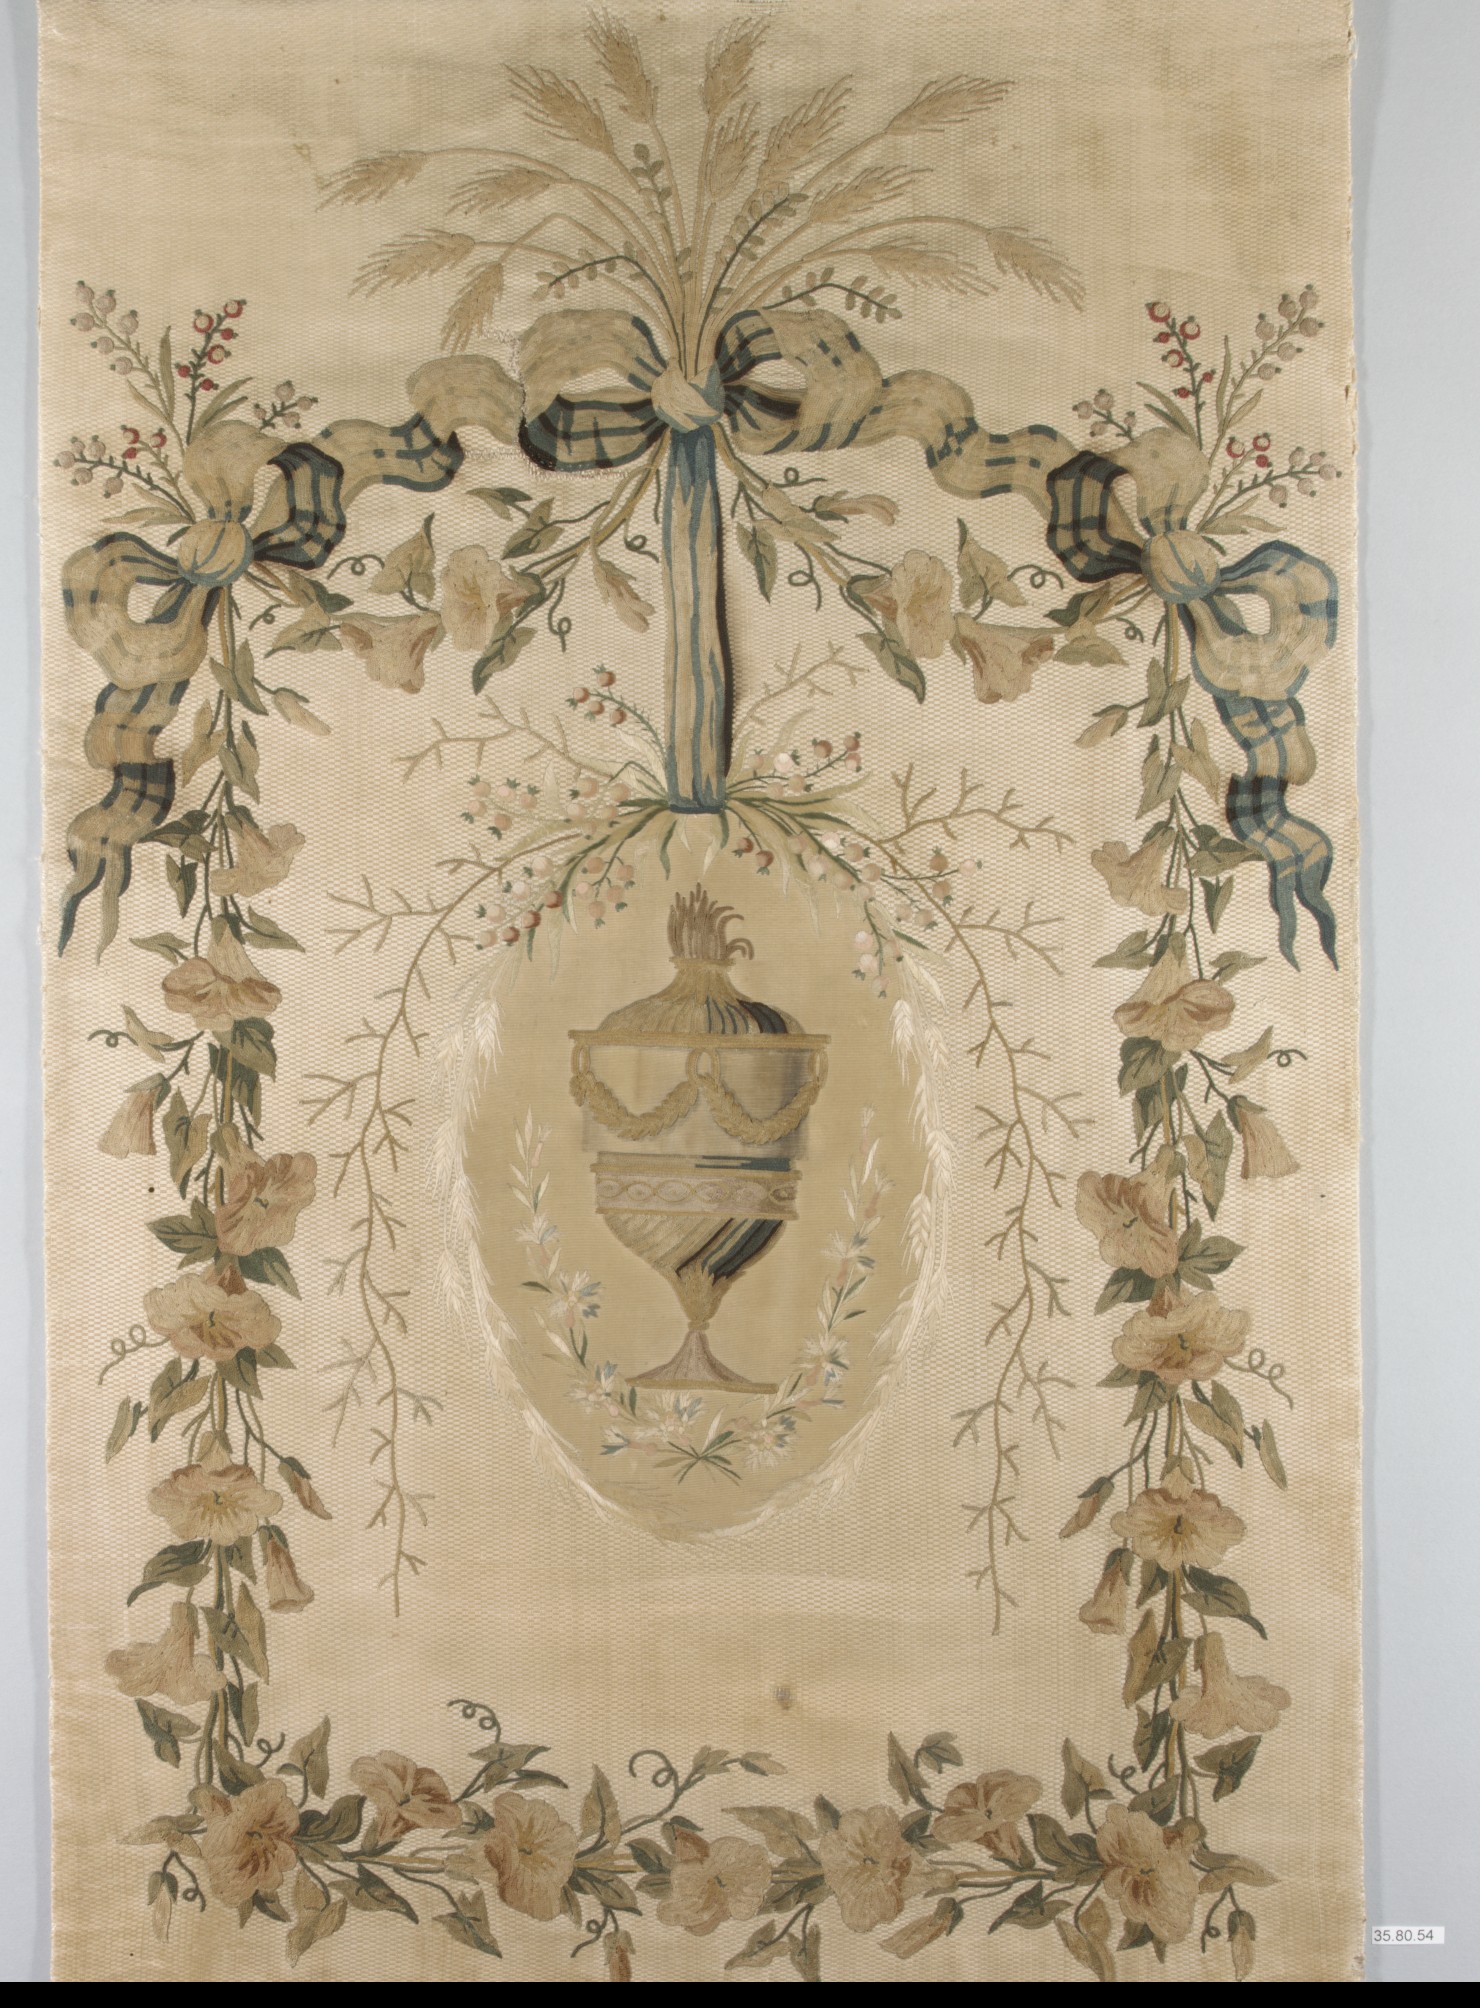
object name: fire screen panel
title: Firescreen panel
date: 1776-1800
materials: silk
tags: flowers